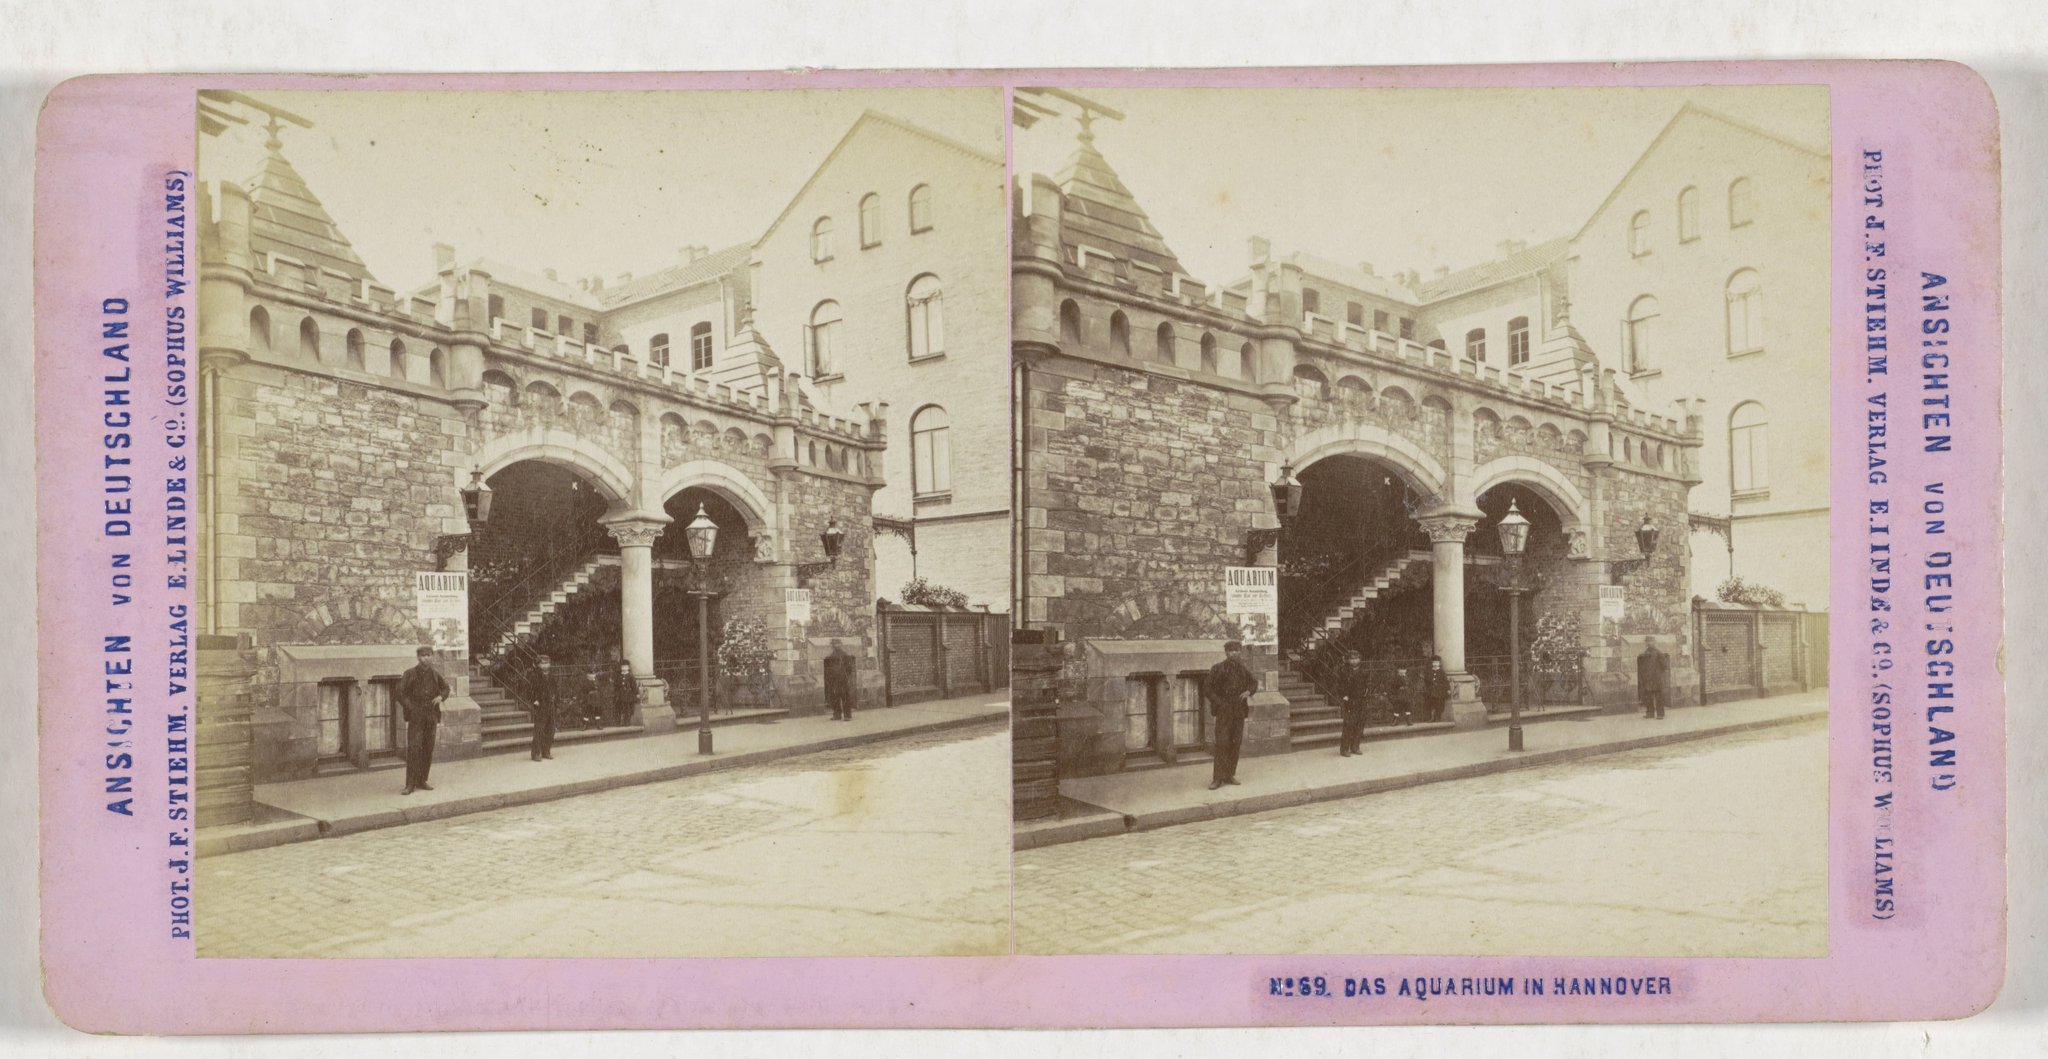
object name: stereograph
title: Ansichten von Deutschland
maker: johann friedrich stiehm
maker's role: fotograaf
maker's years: 1826-1902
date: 1869-1872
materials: cardboard, paper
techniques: albumen print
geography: hannover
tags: aquarium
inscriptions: number: ‘No 69.’